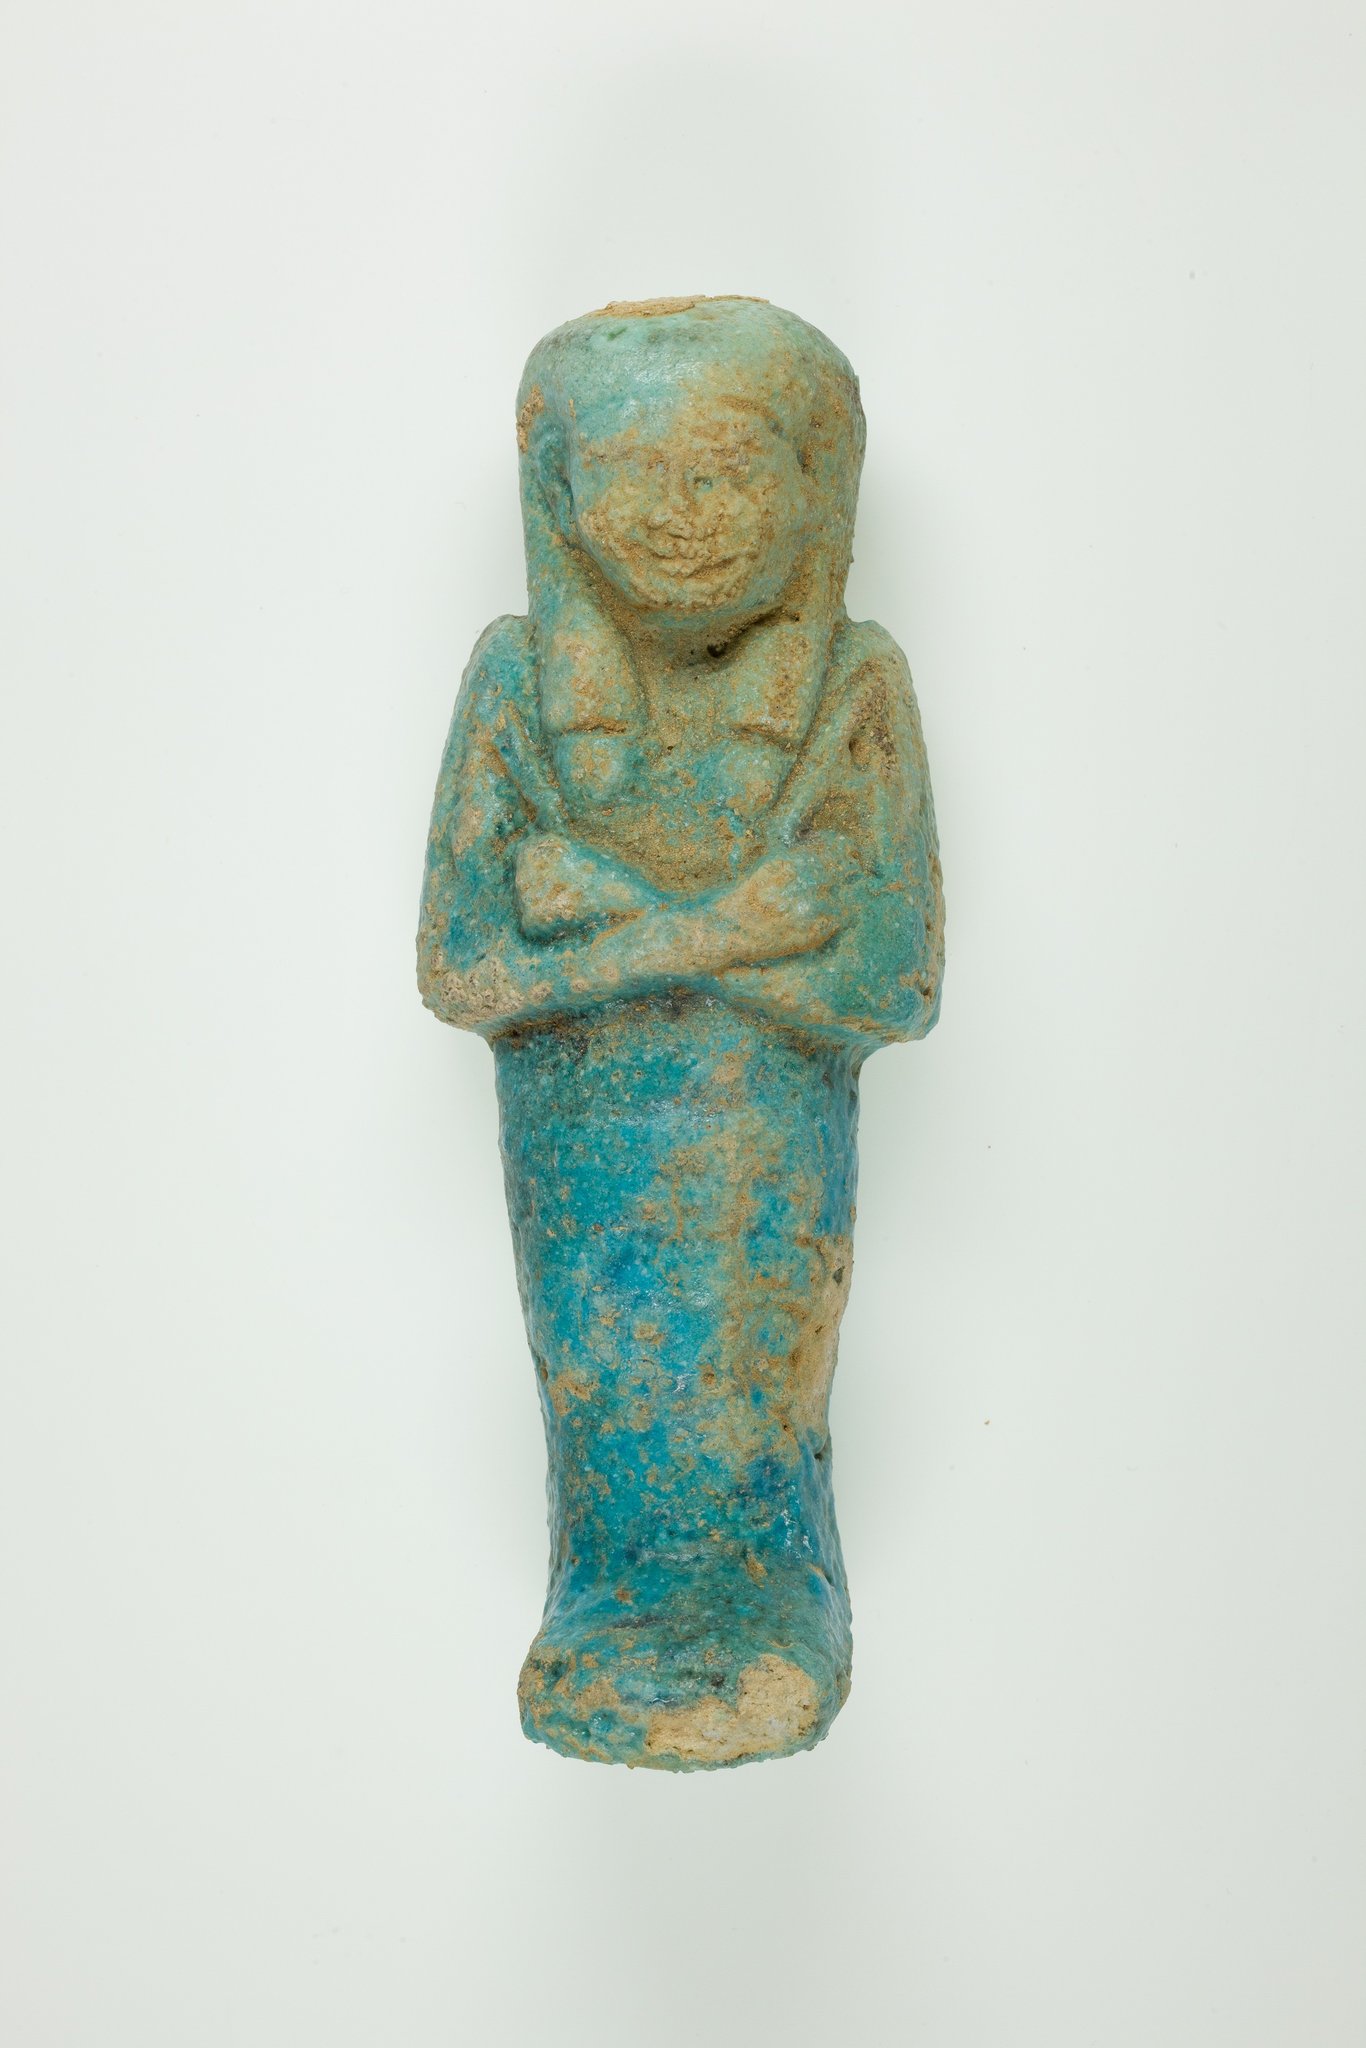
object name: worker shabti, henettawy c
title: Worker Shabti of Henettawy (C), Daughter of Isetemkheb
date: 990-970 BCE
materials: faience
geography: egypt